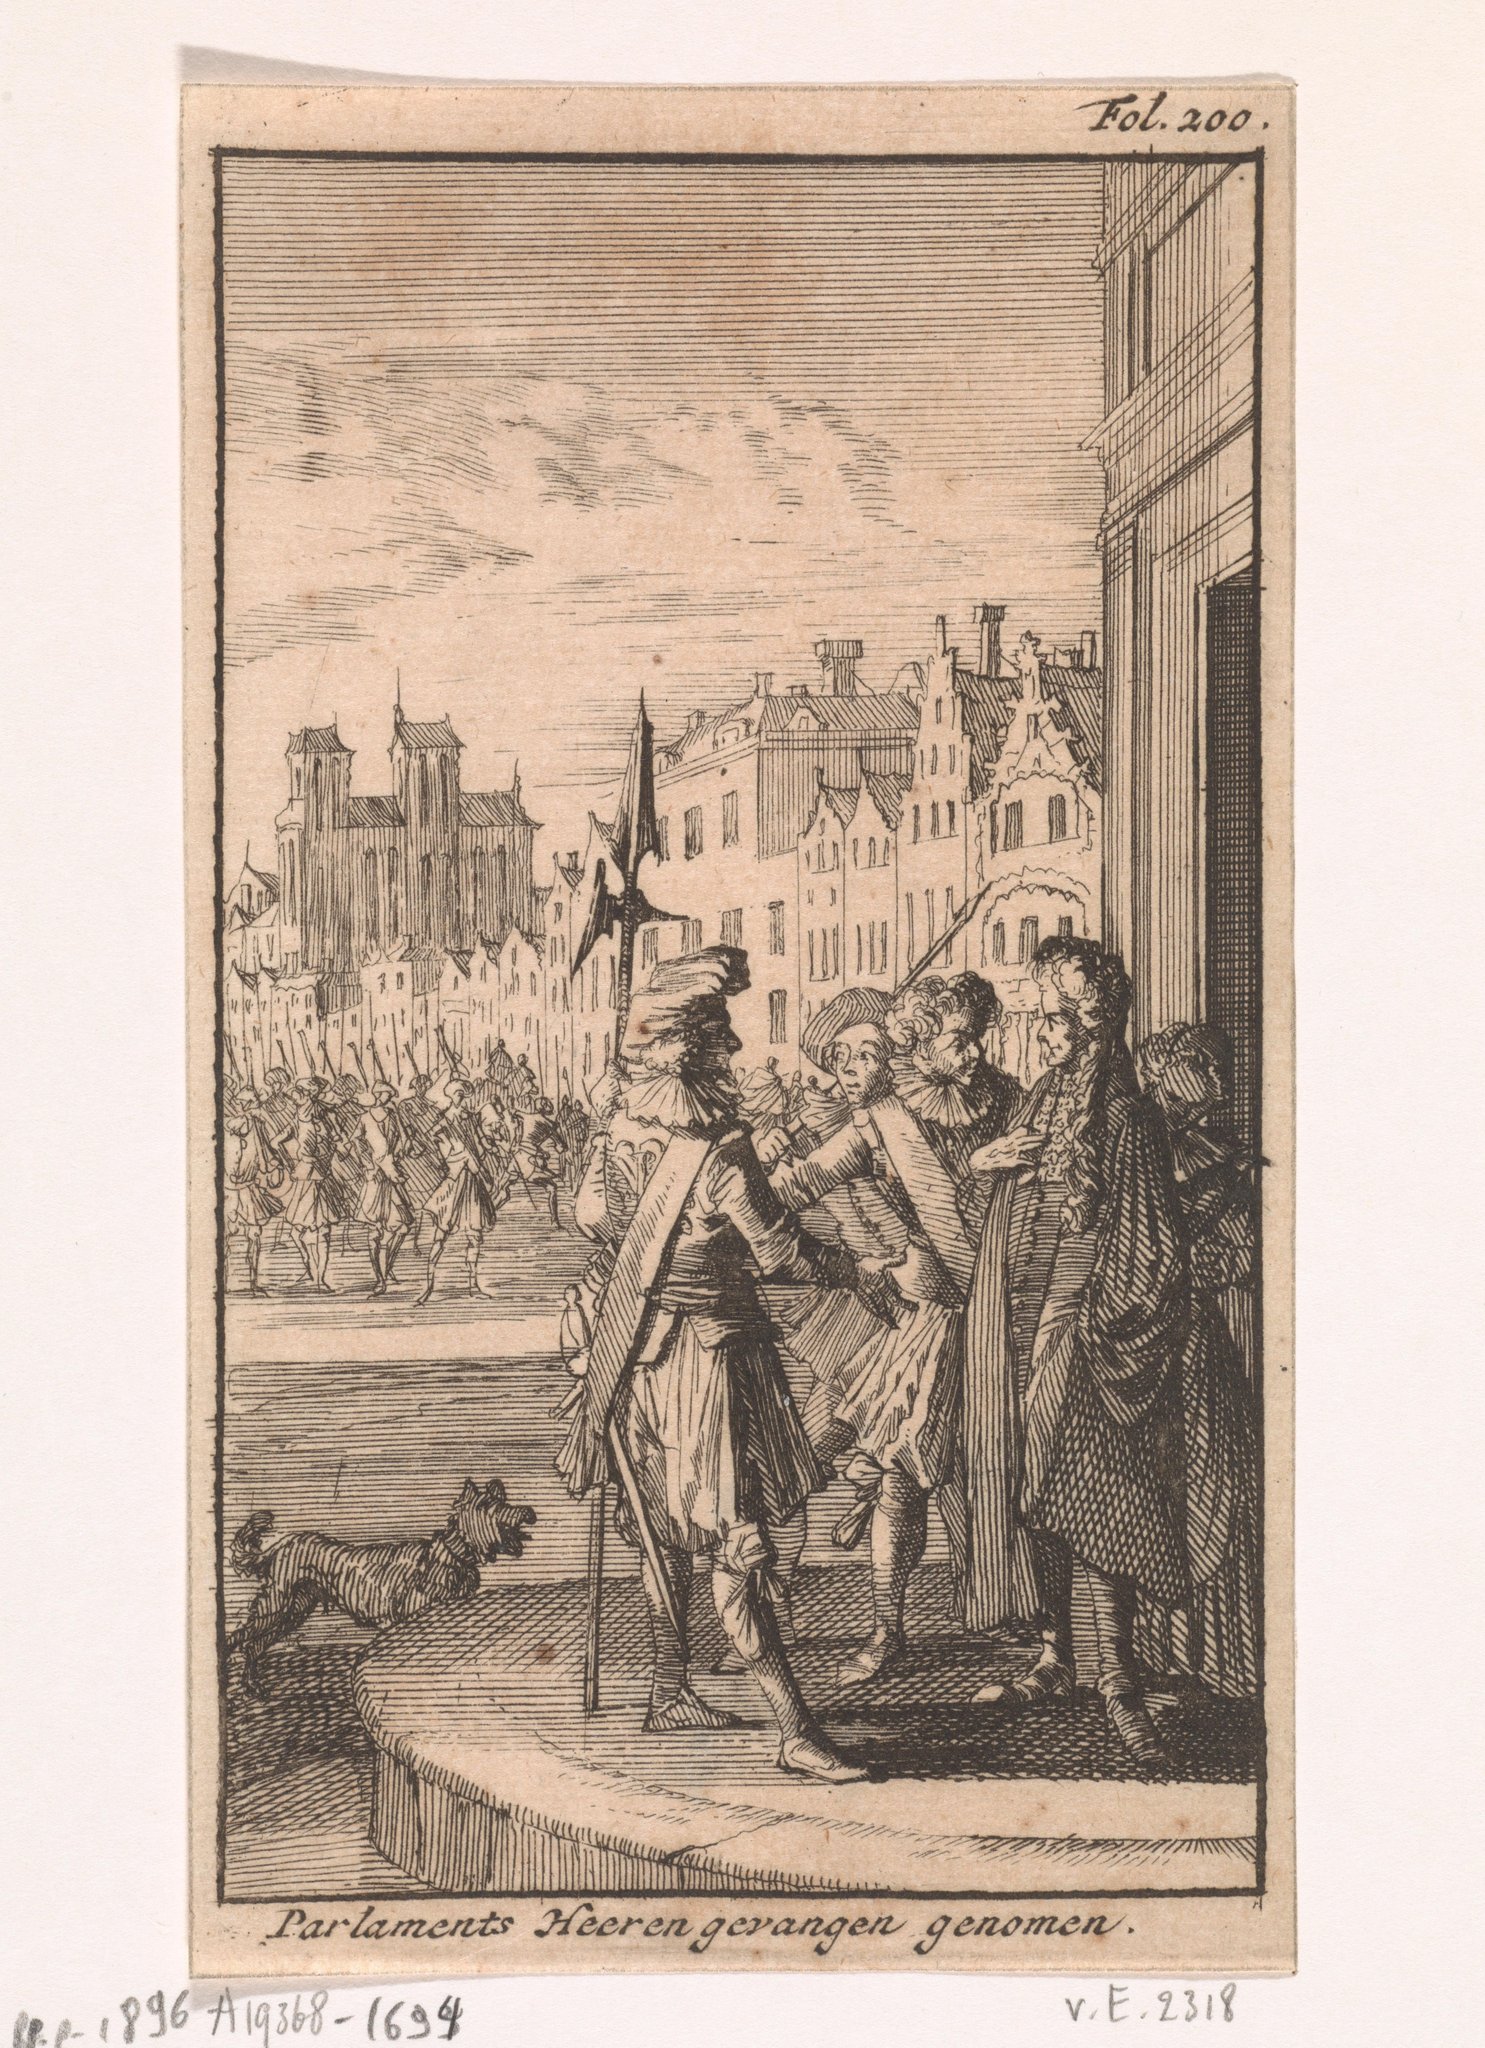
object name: print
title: Parlaments Heeren gevangen genomen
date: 1699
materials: paper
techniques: etching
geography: leiden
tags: jules mazarin, arrest (of criminal), paris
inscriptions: collector's mark: Lugt 2228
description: Boekillustratie voor Het leven en bedryf van den wytberoemden en grooten staatkundigen Julius Mazaryn. Leiden: Boudewijn van der Aa, 1699, dl. 1, f. 200.